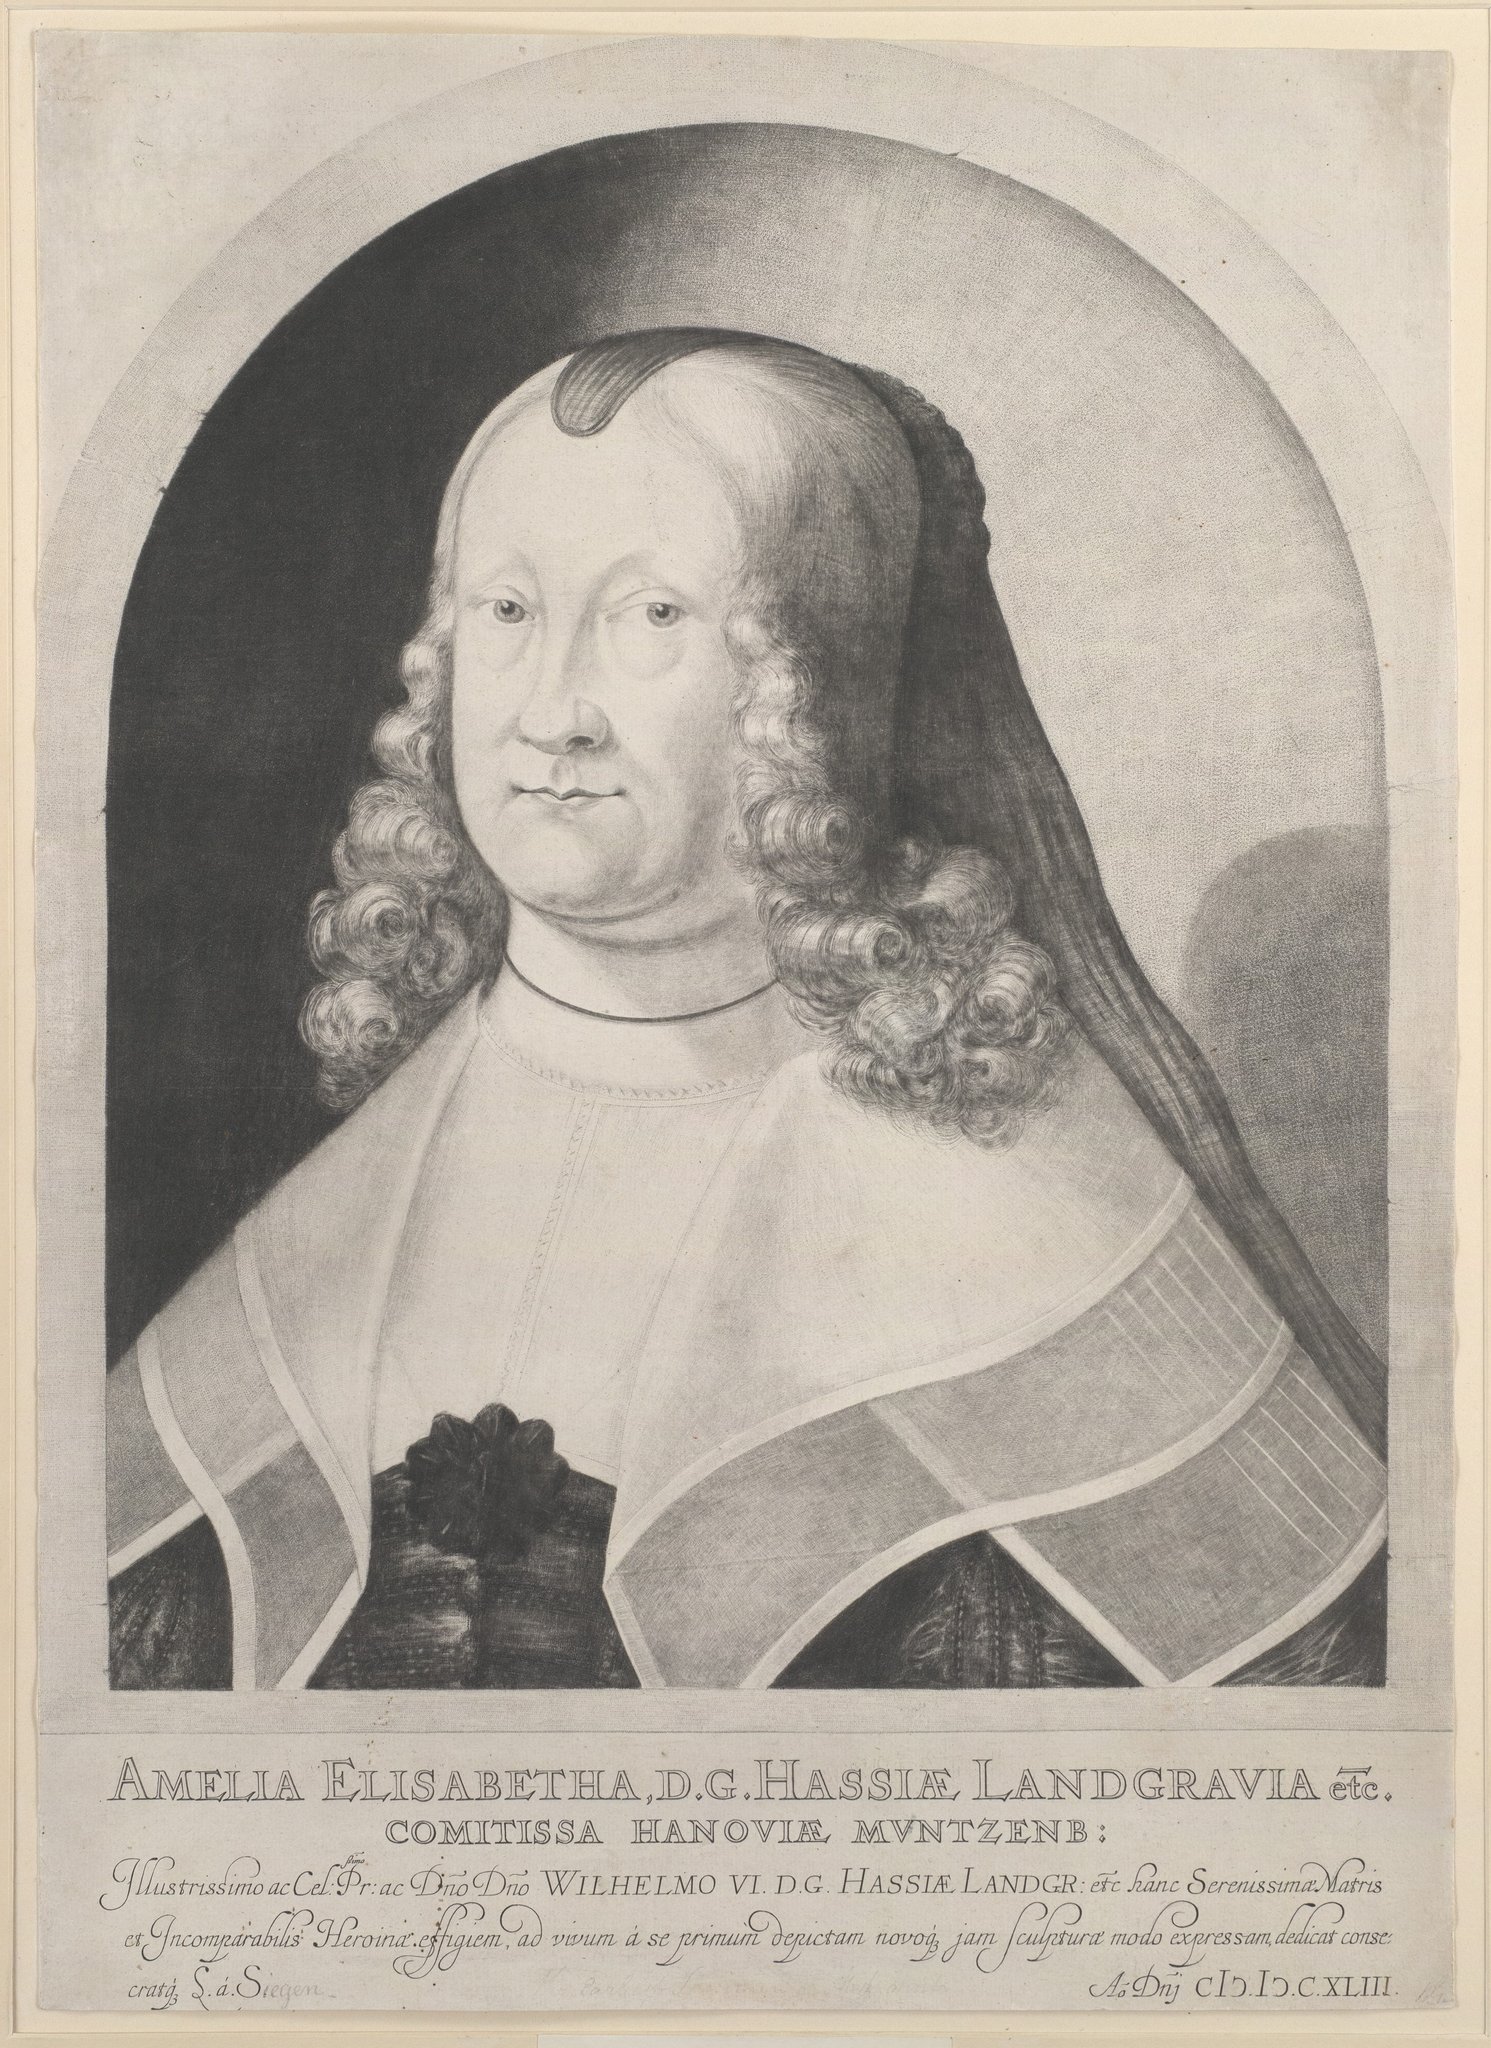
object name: print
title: Amelia Elizabeth, Landgravine of Hesse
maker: ludwig von siegen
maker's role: print maker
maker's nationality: german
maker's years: 1609-1680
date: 1601-1700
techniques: mezzotint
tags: portraits,women